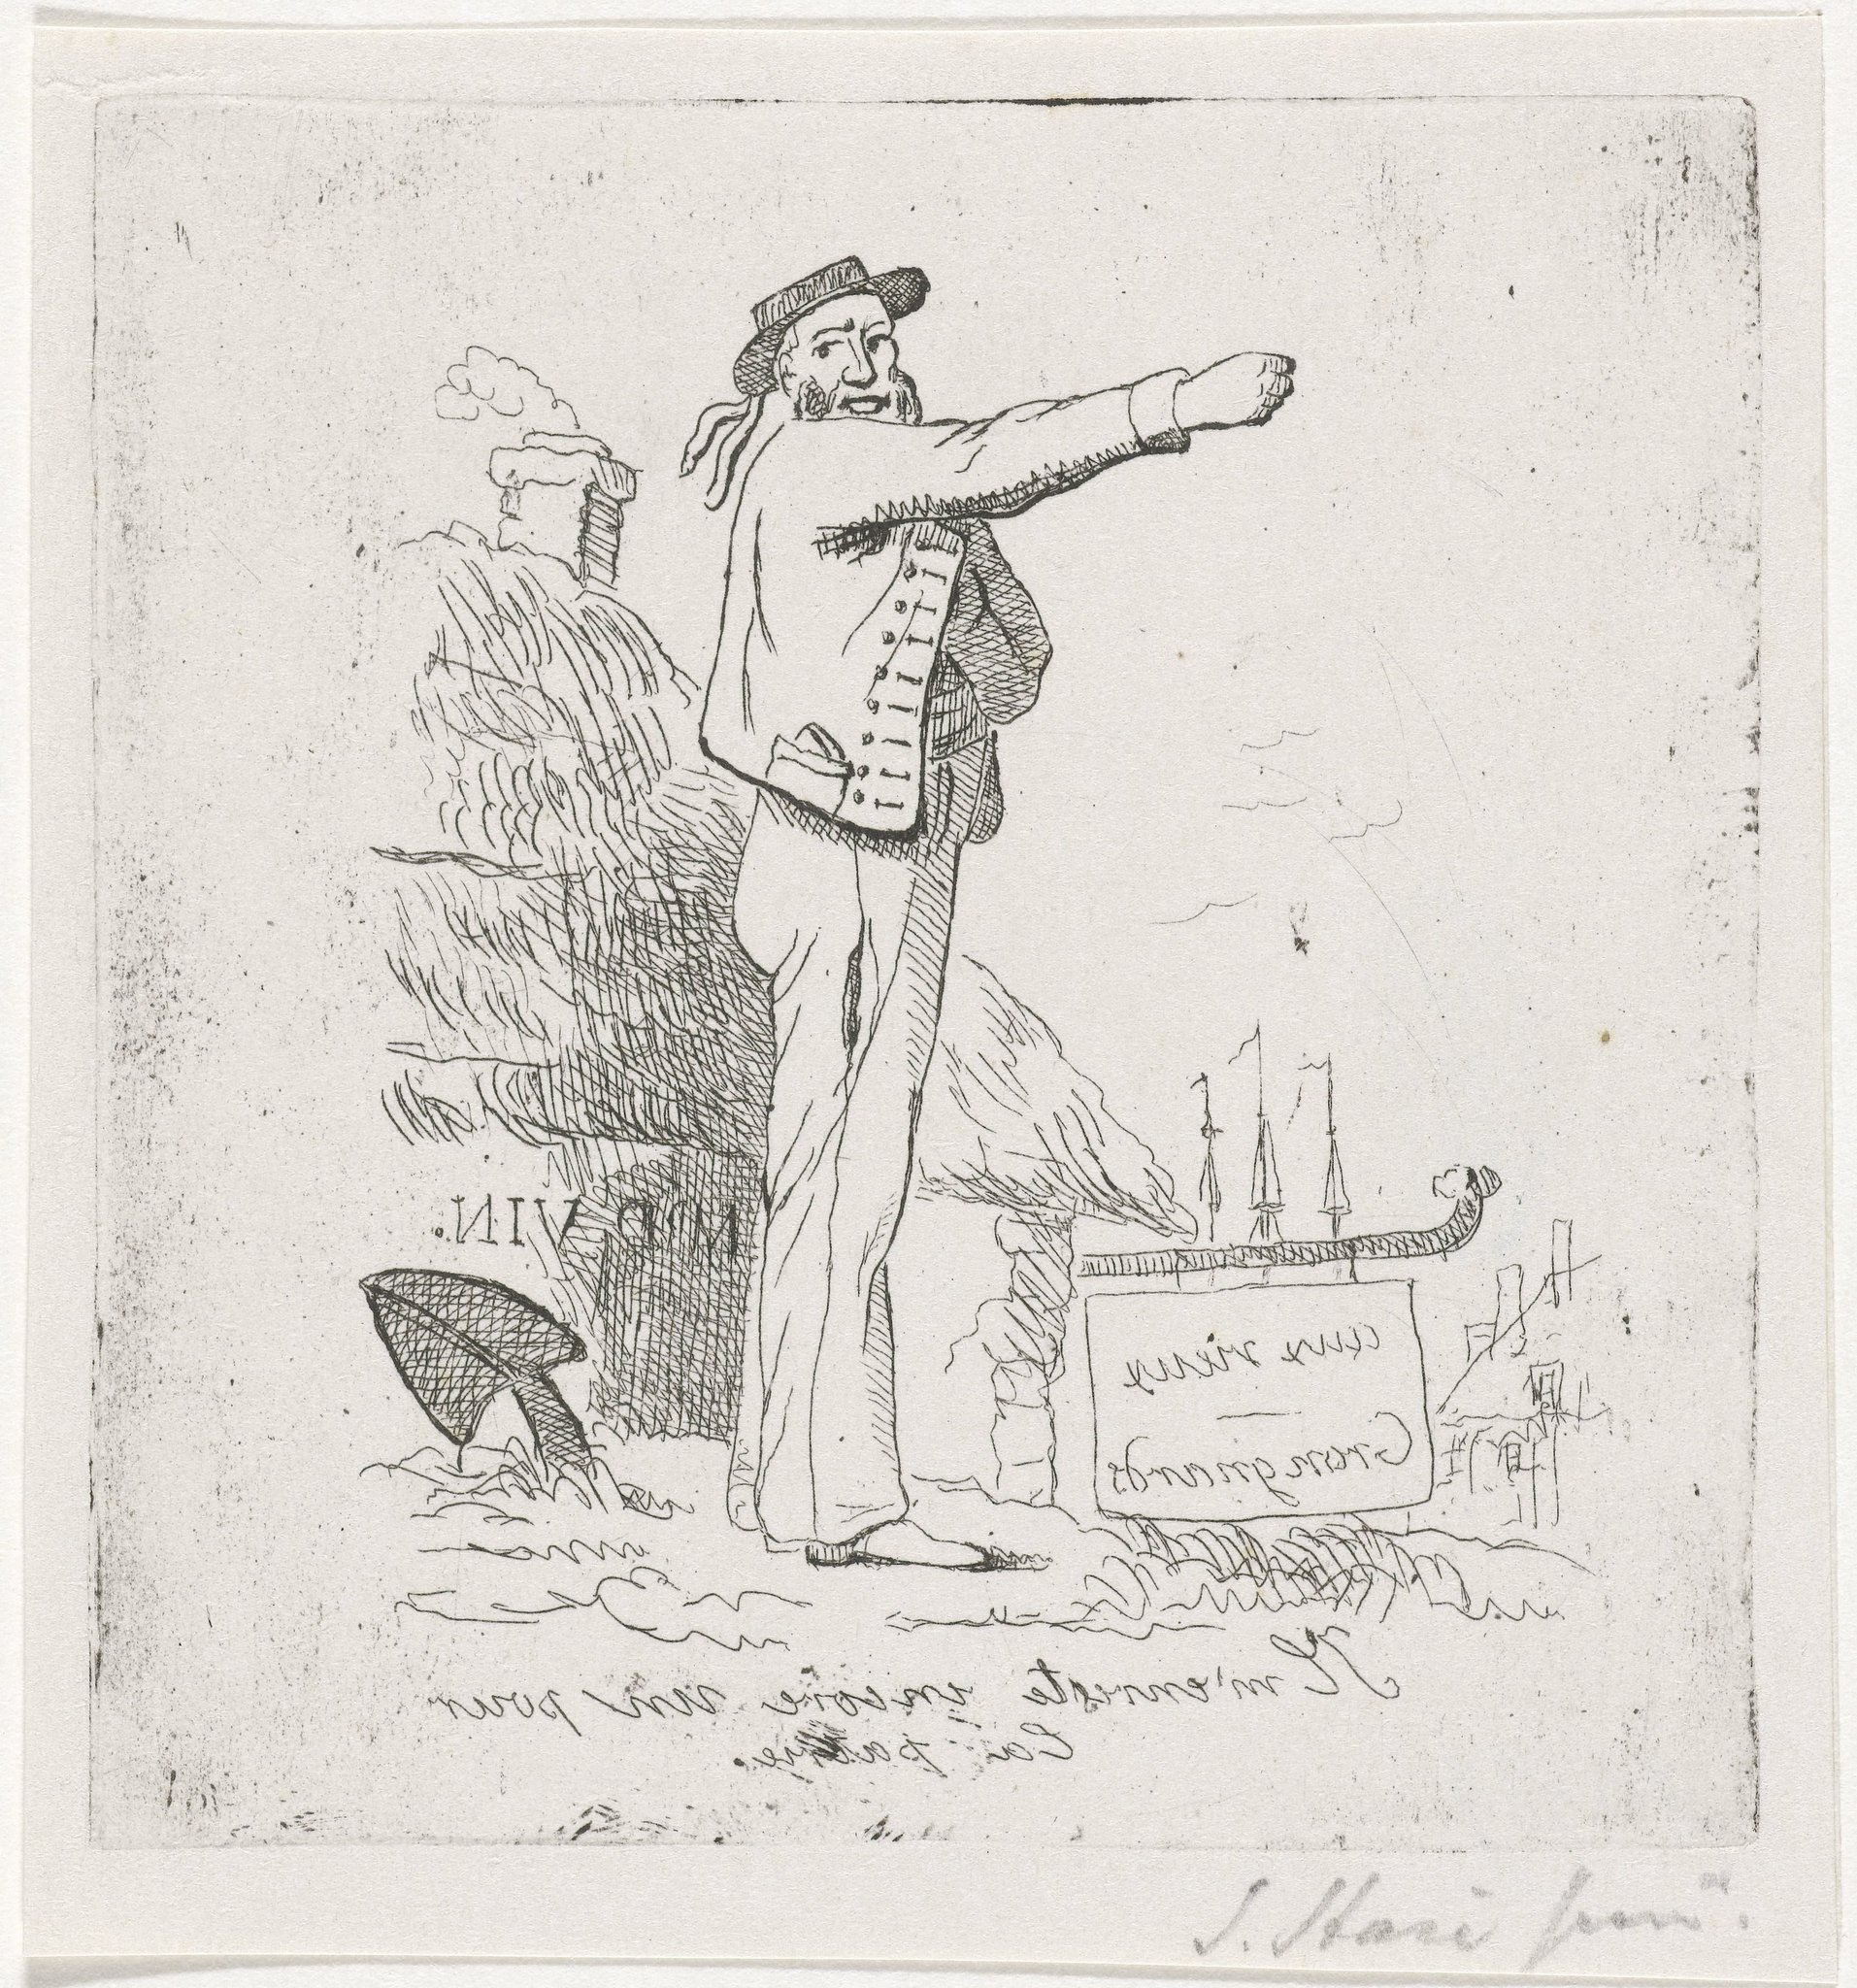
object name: print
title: Man met uitgestrekte arm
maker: johannes hari (ii)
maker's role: painter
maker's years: 1807-1887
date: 1817-1882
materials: paper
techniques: etching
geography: the hague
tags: arm stretched forward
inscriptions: collector's mark: Lugt 2228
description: Een man staande op een duin bij een huis strekt de rechterarm uit. Naast hem een uithangbord met in spiegelschrift de tekst: aux vieux Grongnards. Onderaan in spiegelschrift: Il m'en reste encore un pour la patrie.